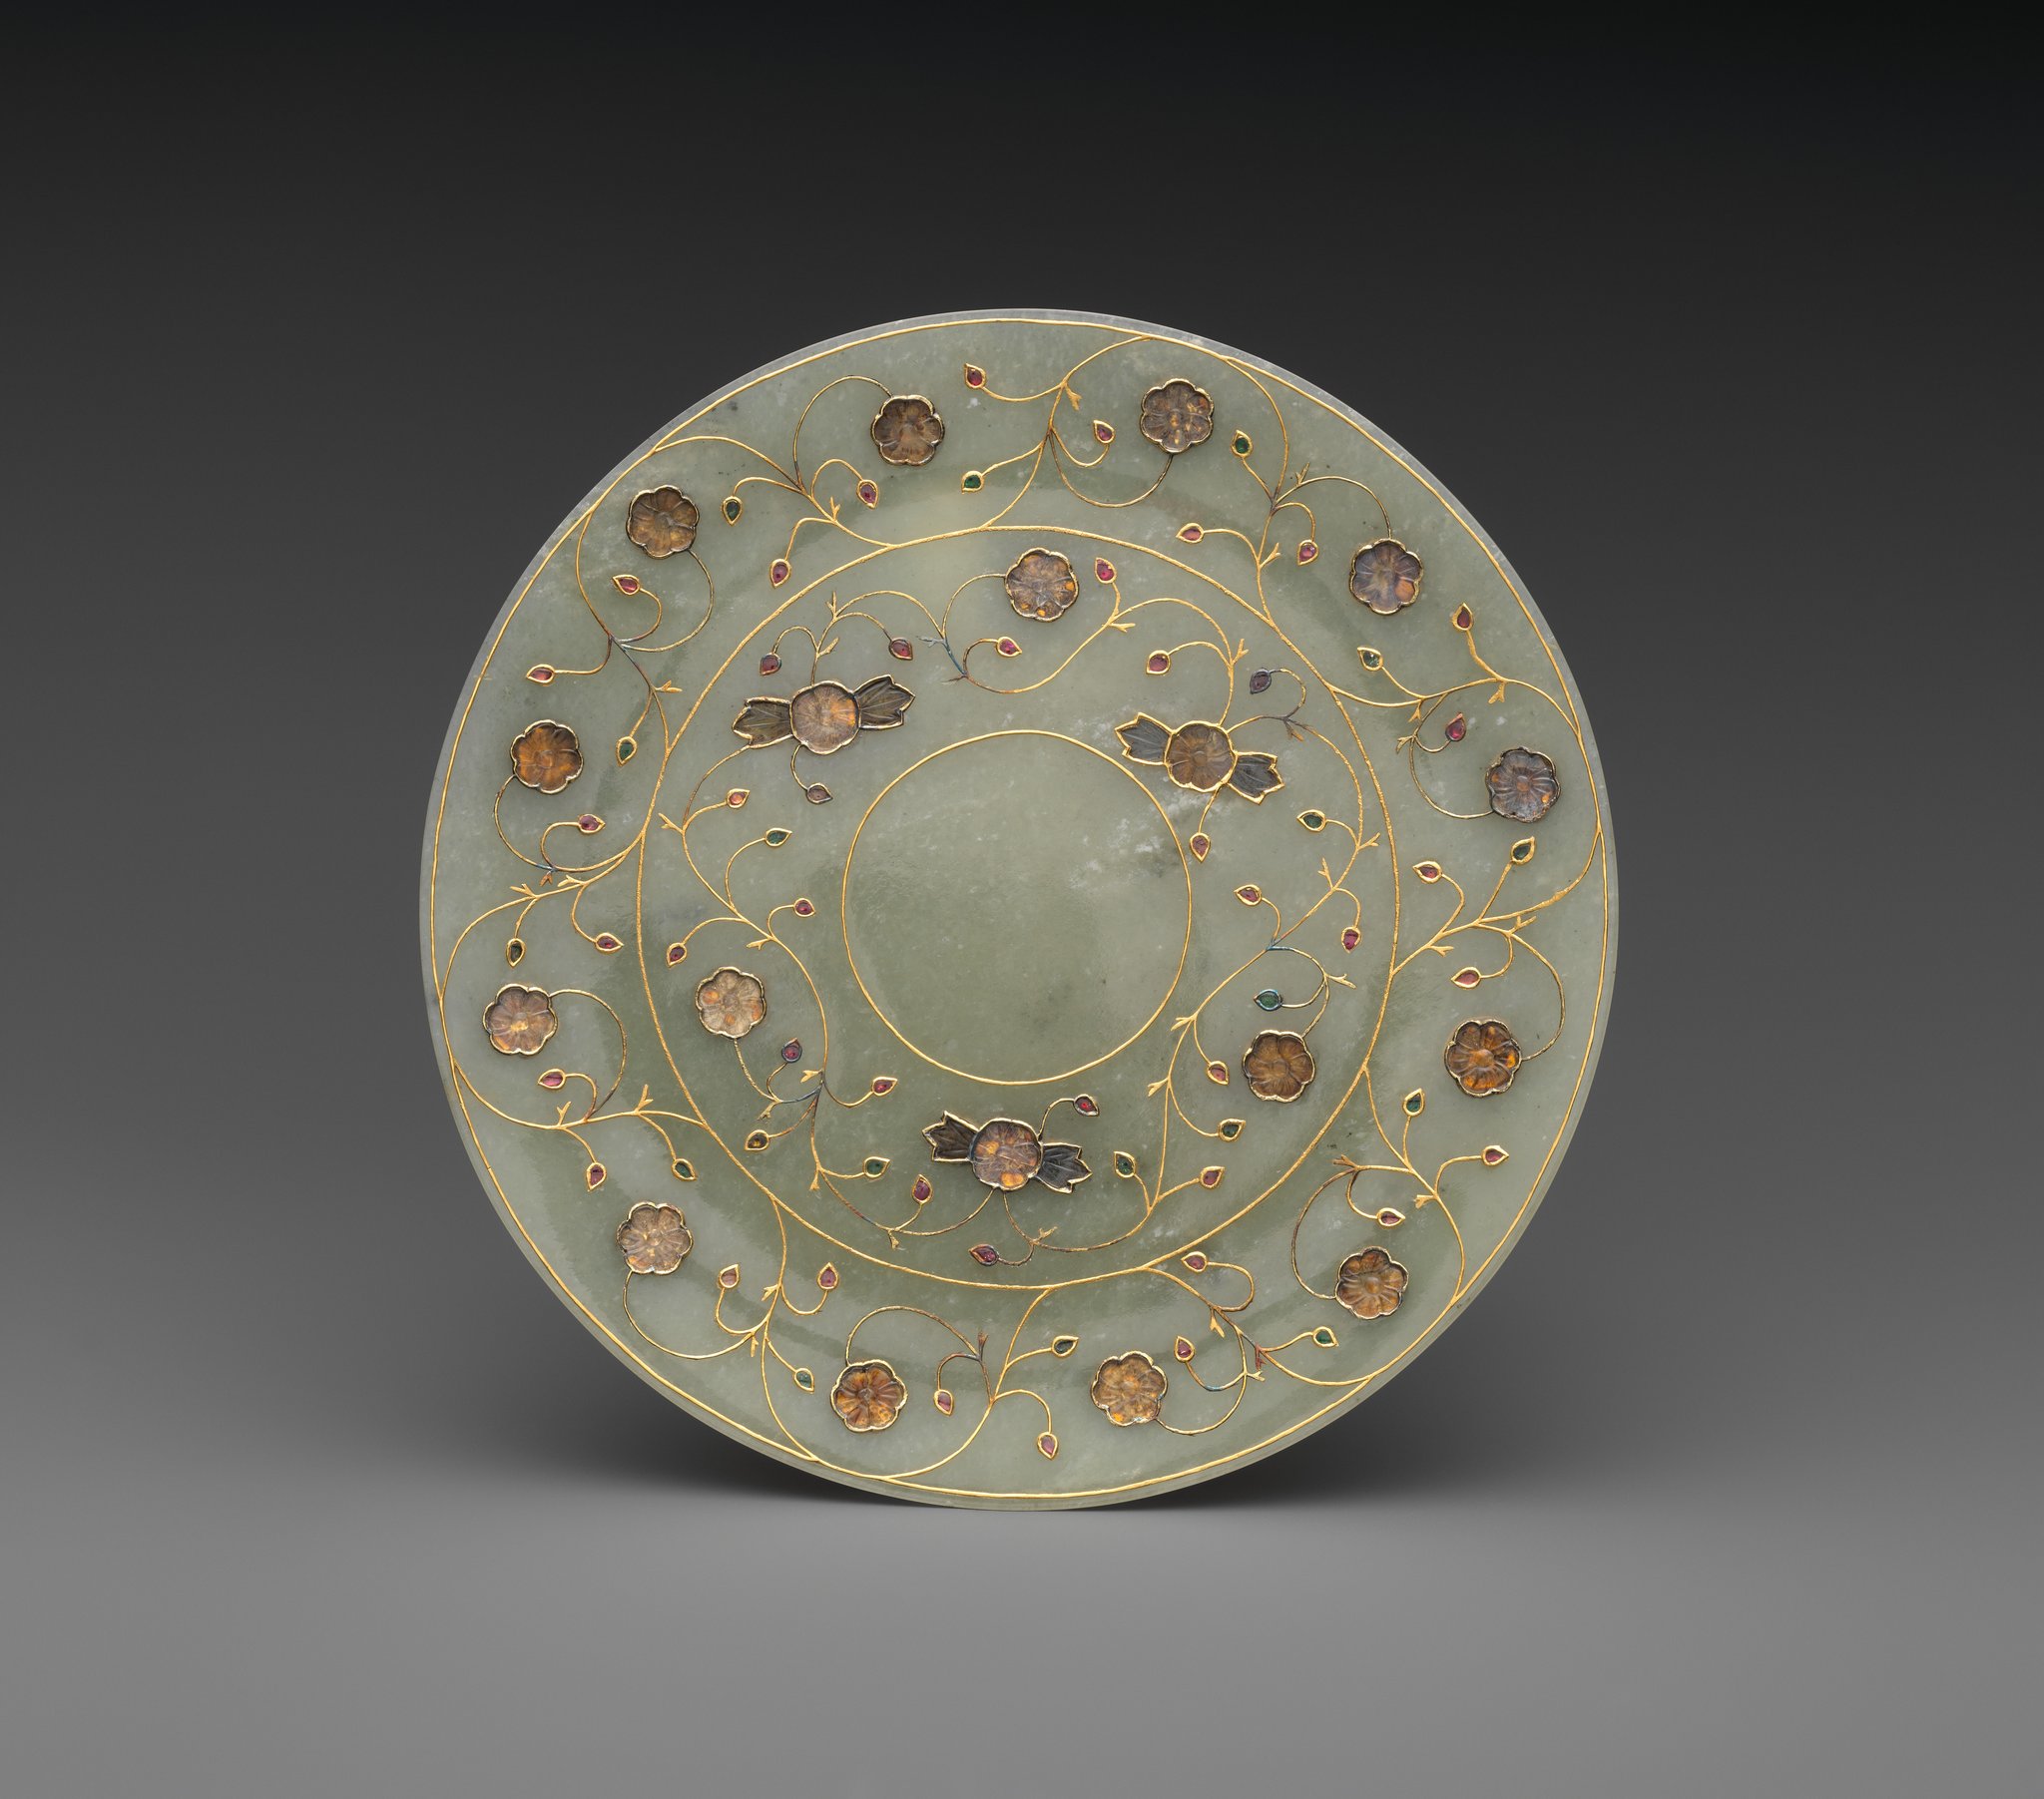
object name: plate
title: Jewelled plate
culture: indian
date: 1701-1900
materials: gold, jade, stone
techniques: inlay